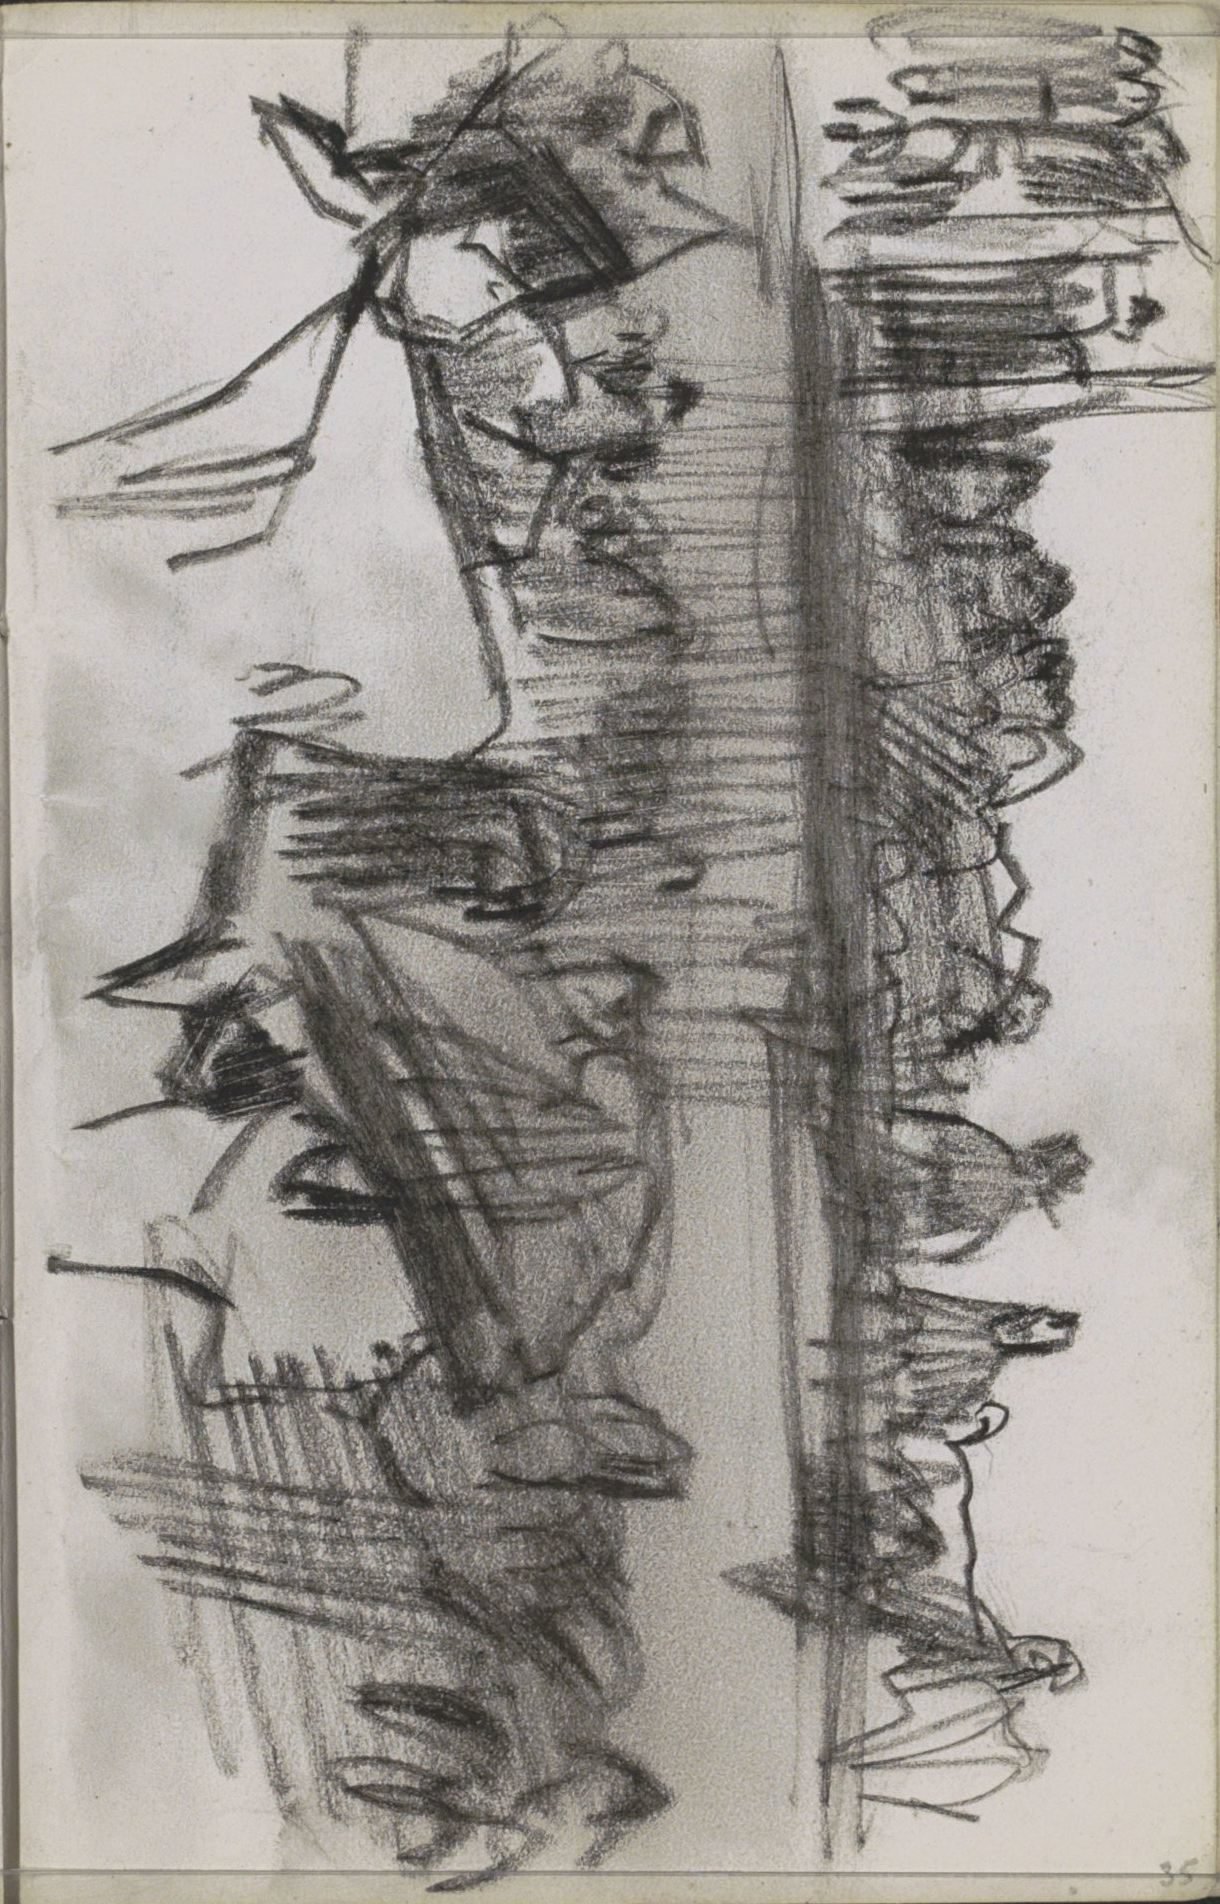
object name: sketchbook leaf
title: Groep figuren, mogelijk een menigte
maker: isaac israels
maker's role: draughtsman, painter, print maker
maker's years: 1865-1934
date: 1875-1934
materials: chalk, paper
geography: amsterdam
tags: adult woman, adult man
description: Pagina 35 uit schetsboek XXIX met 44 pagina's.